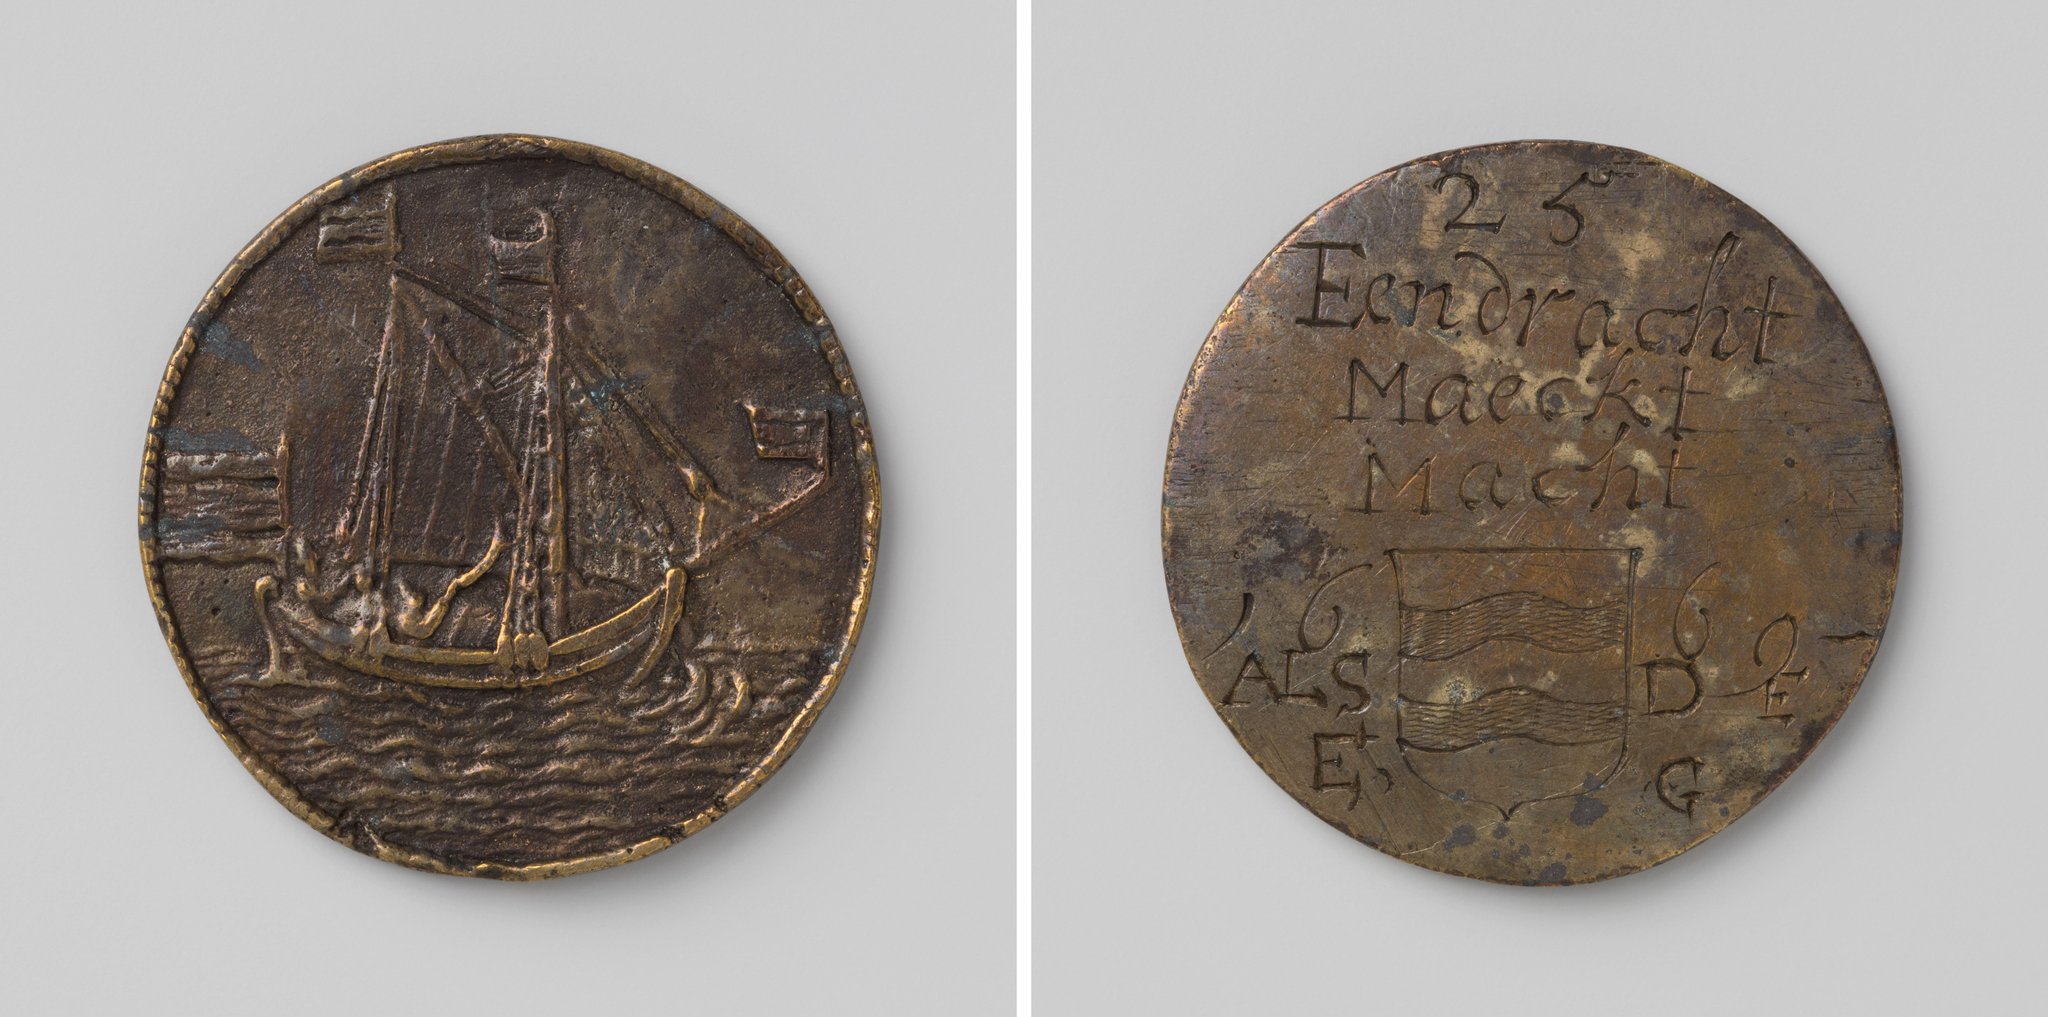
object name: medal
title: Loods- of veerschippersgilde van Sluis, gildepenning met no. 25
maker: Anonymous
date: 1669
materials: brass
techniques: casting, engraving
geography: sluis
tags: sluis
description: Guilds were urban organisations of people in specific occupations. The guild represented the interests of the profession. Each member had a token as proof of membership. The person’s name was engraved on one side of the token, often together with the arms of the guild or of the city in which it was based. The other side carried a motif signifying the occupation represented by the guild.